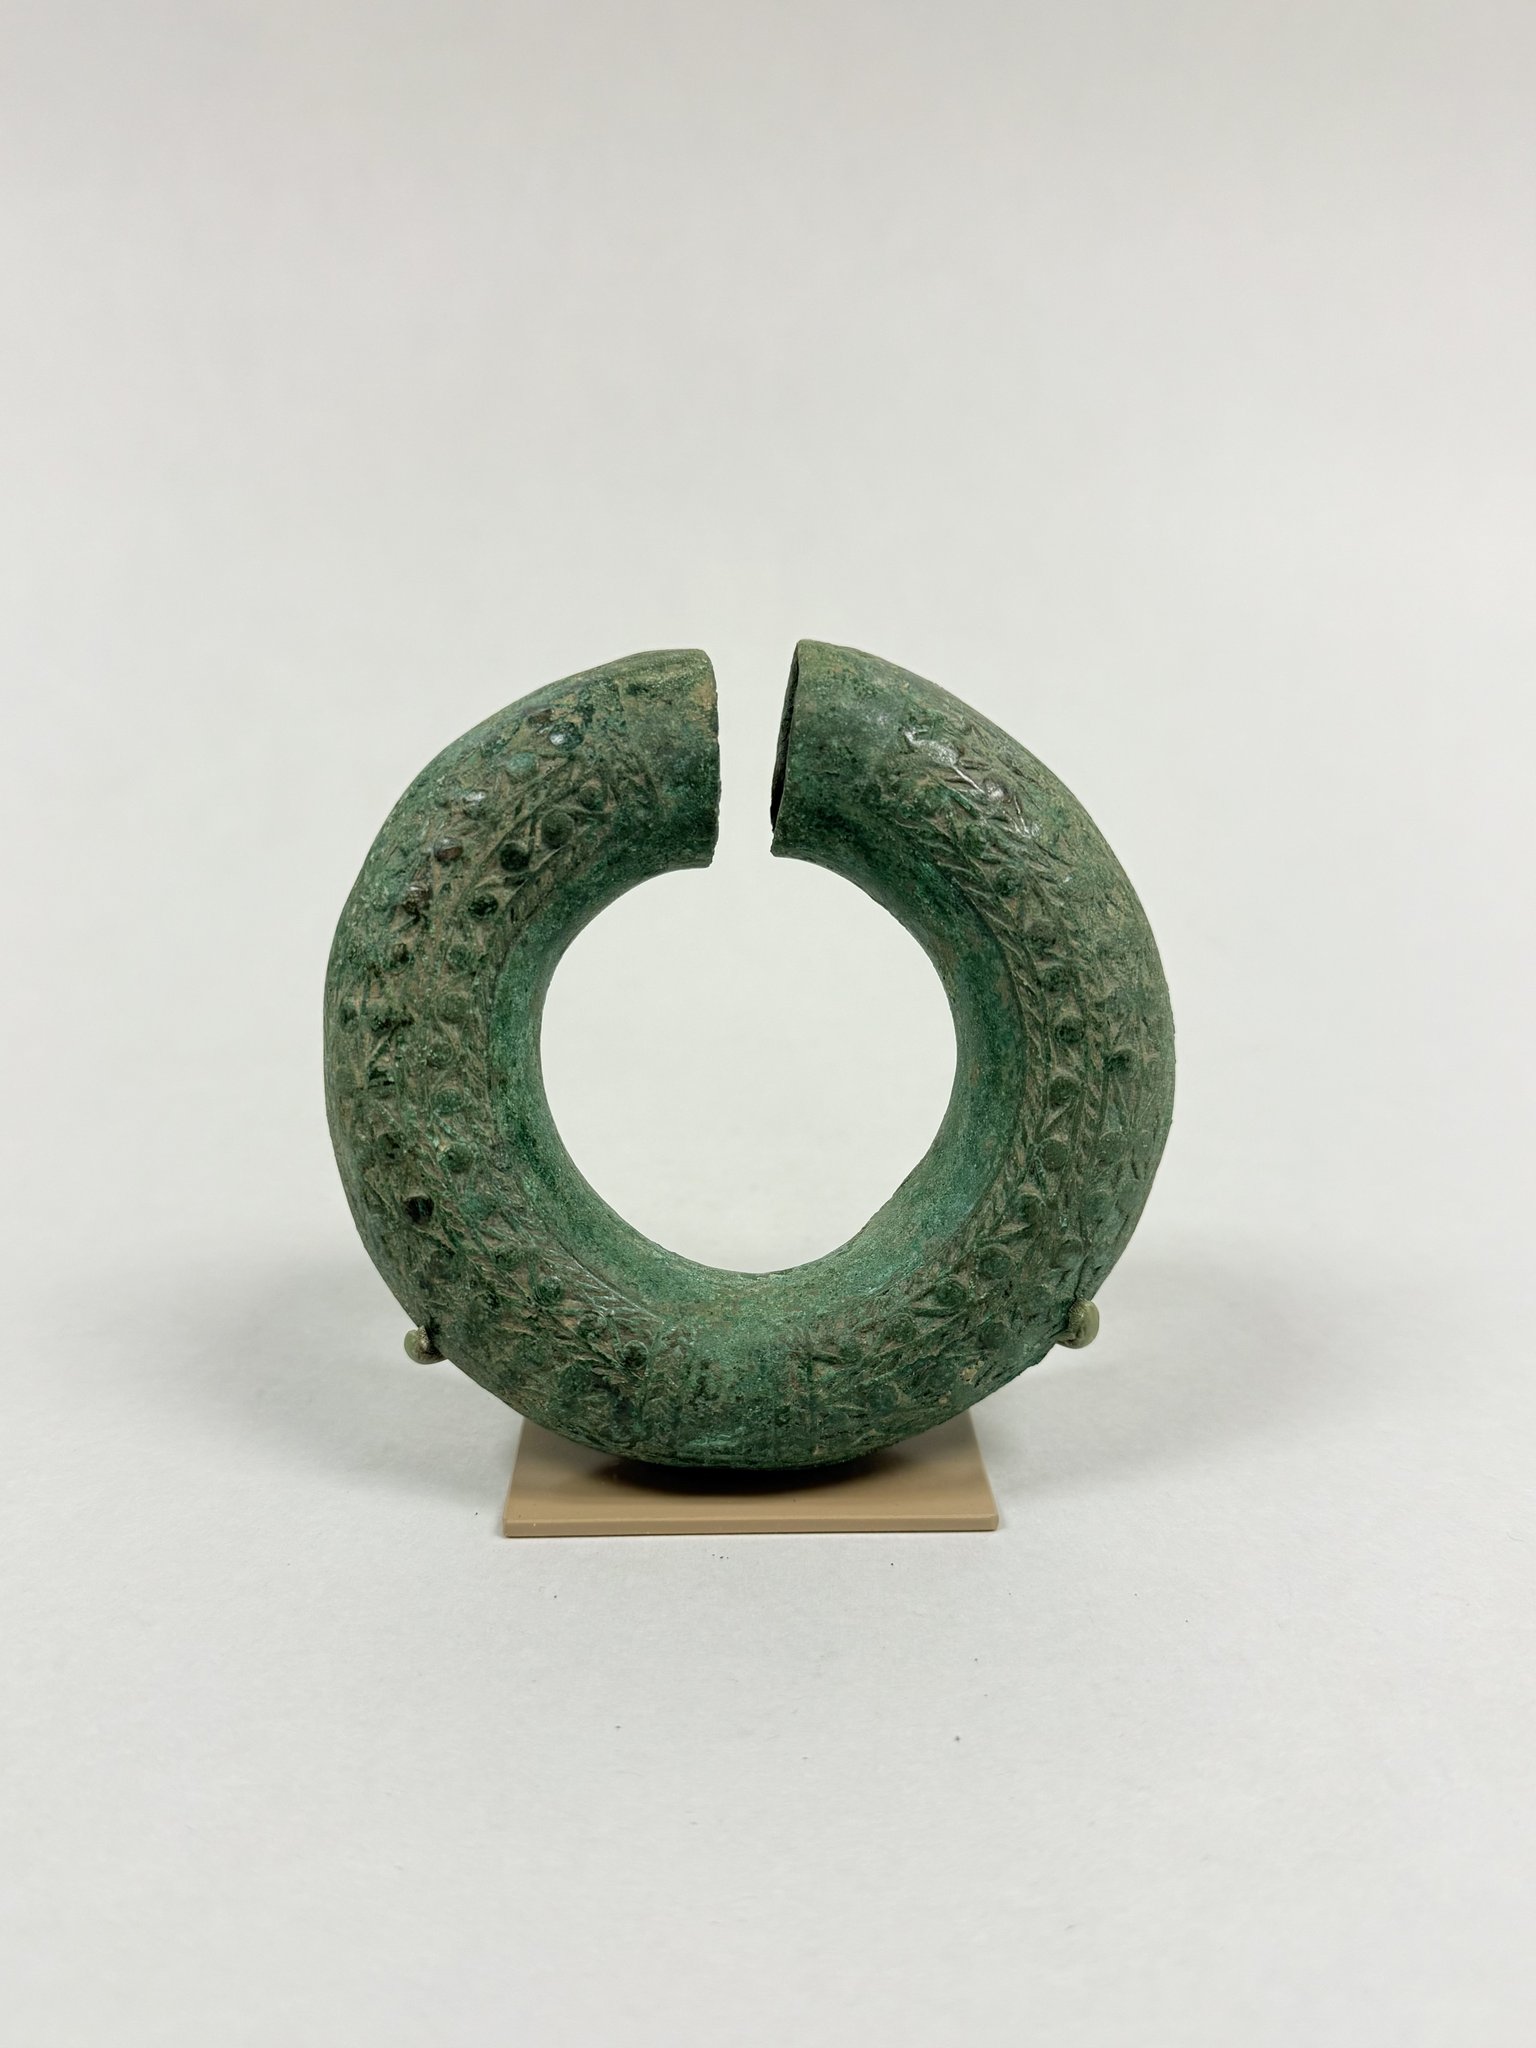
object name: bangle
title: Bangle with Circular Pattern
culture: thai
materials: bronze